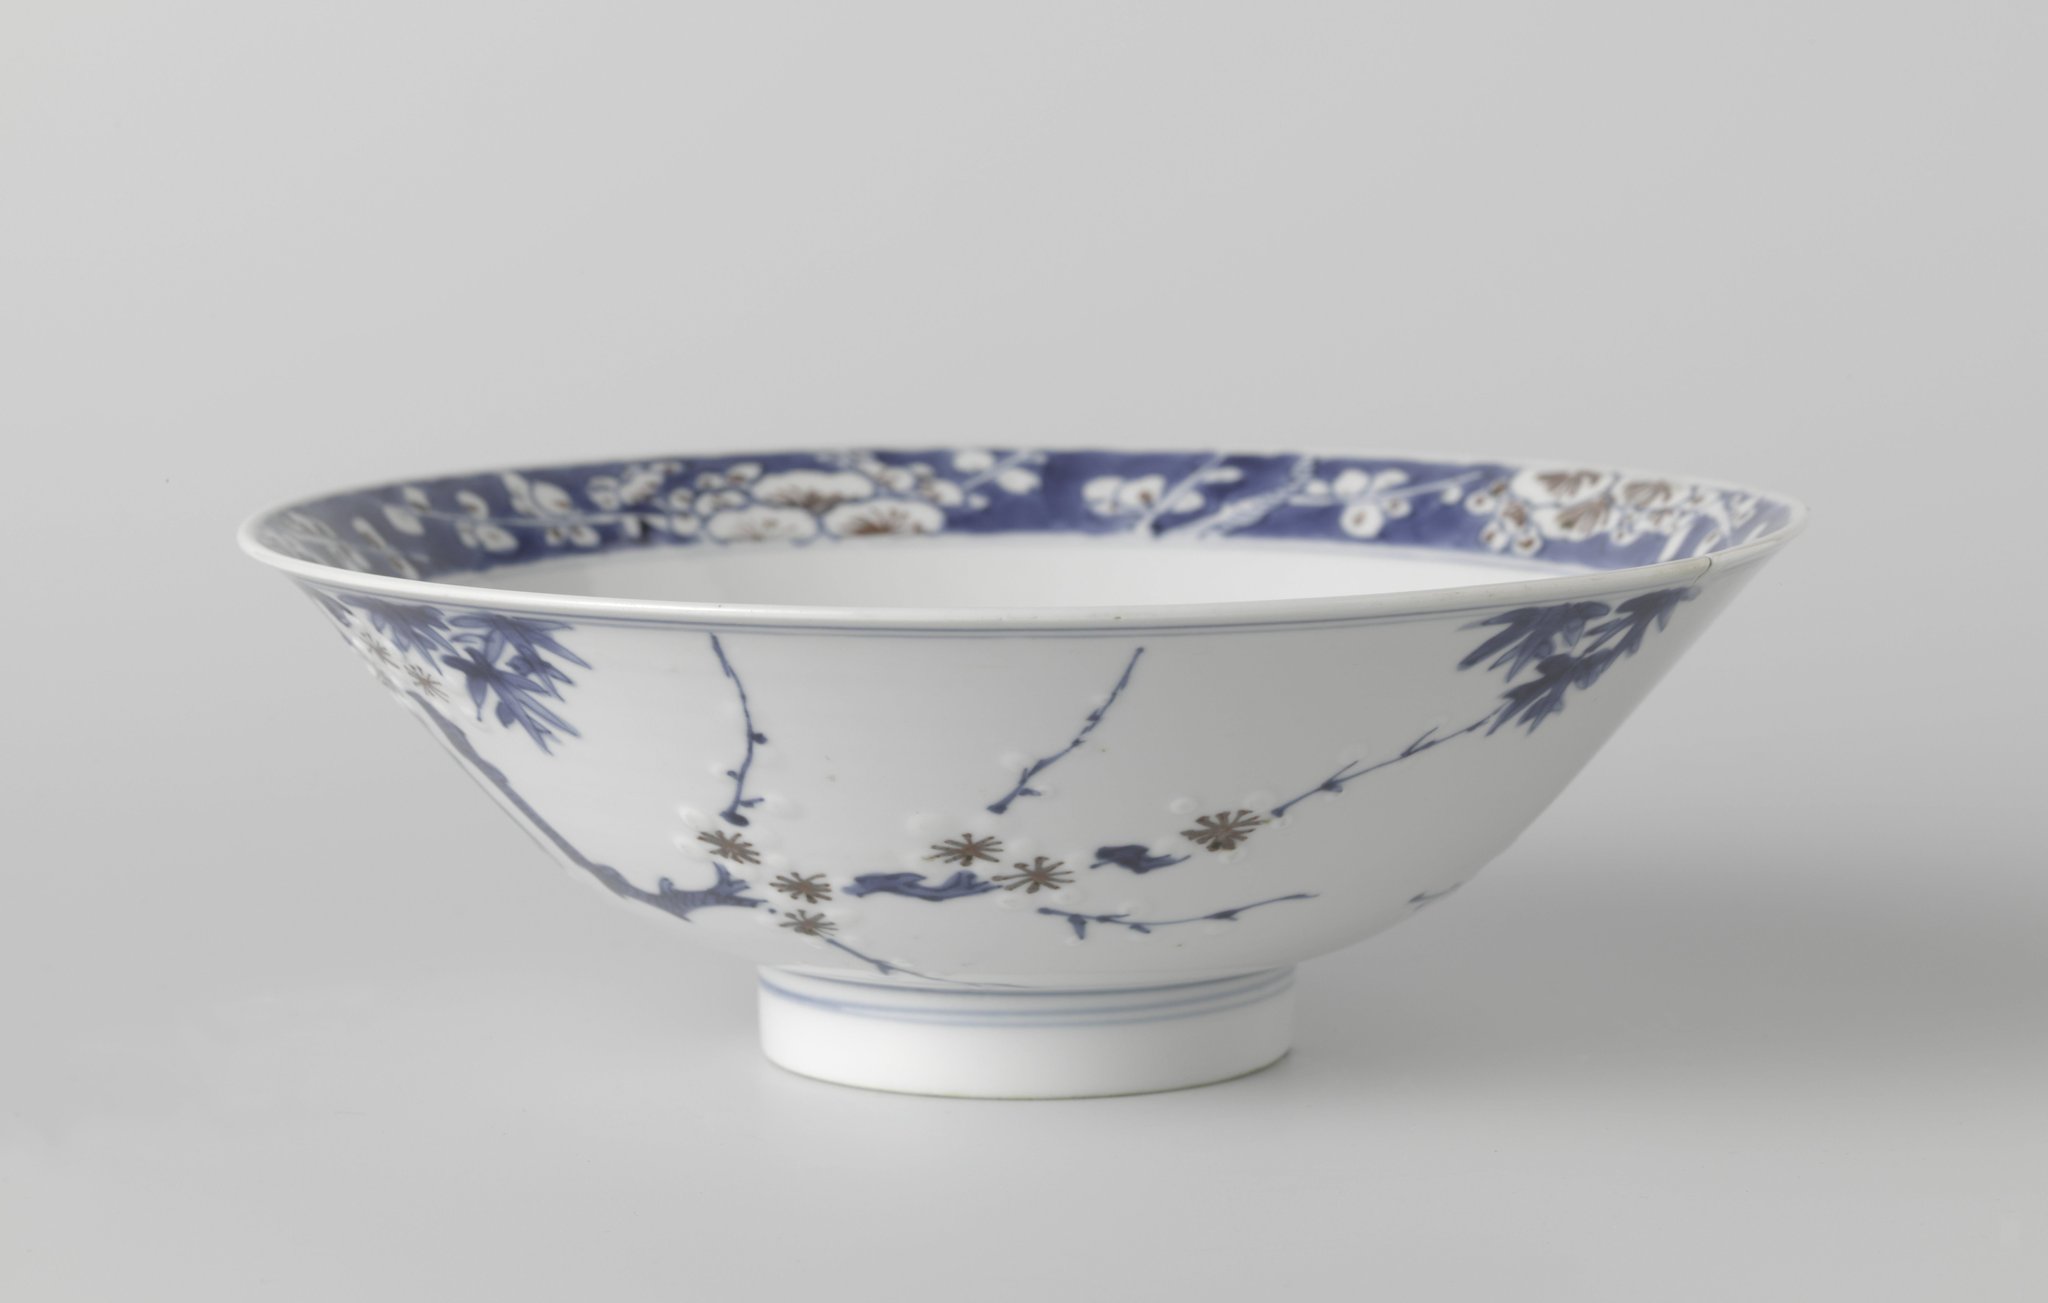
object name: bowl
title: Bowl with prunus sprays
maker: Anonymous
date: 1675-1699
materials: cobalt, copper, glaze, paint, porcelain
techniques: firing, turning, vitrification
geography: china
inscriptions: mark